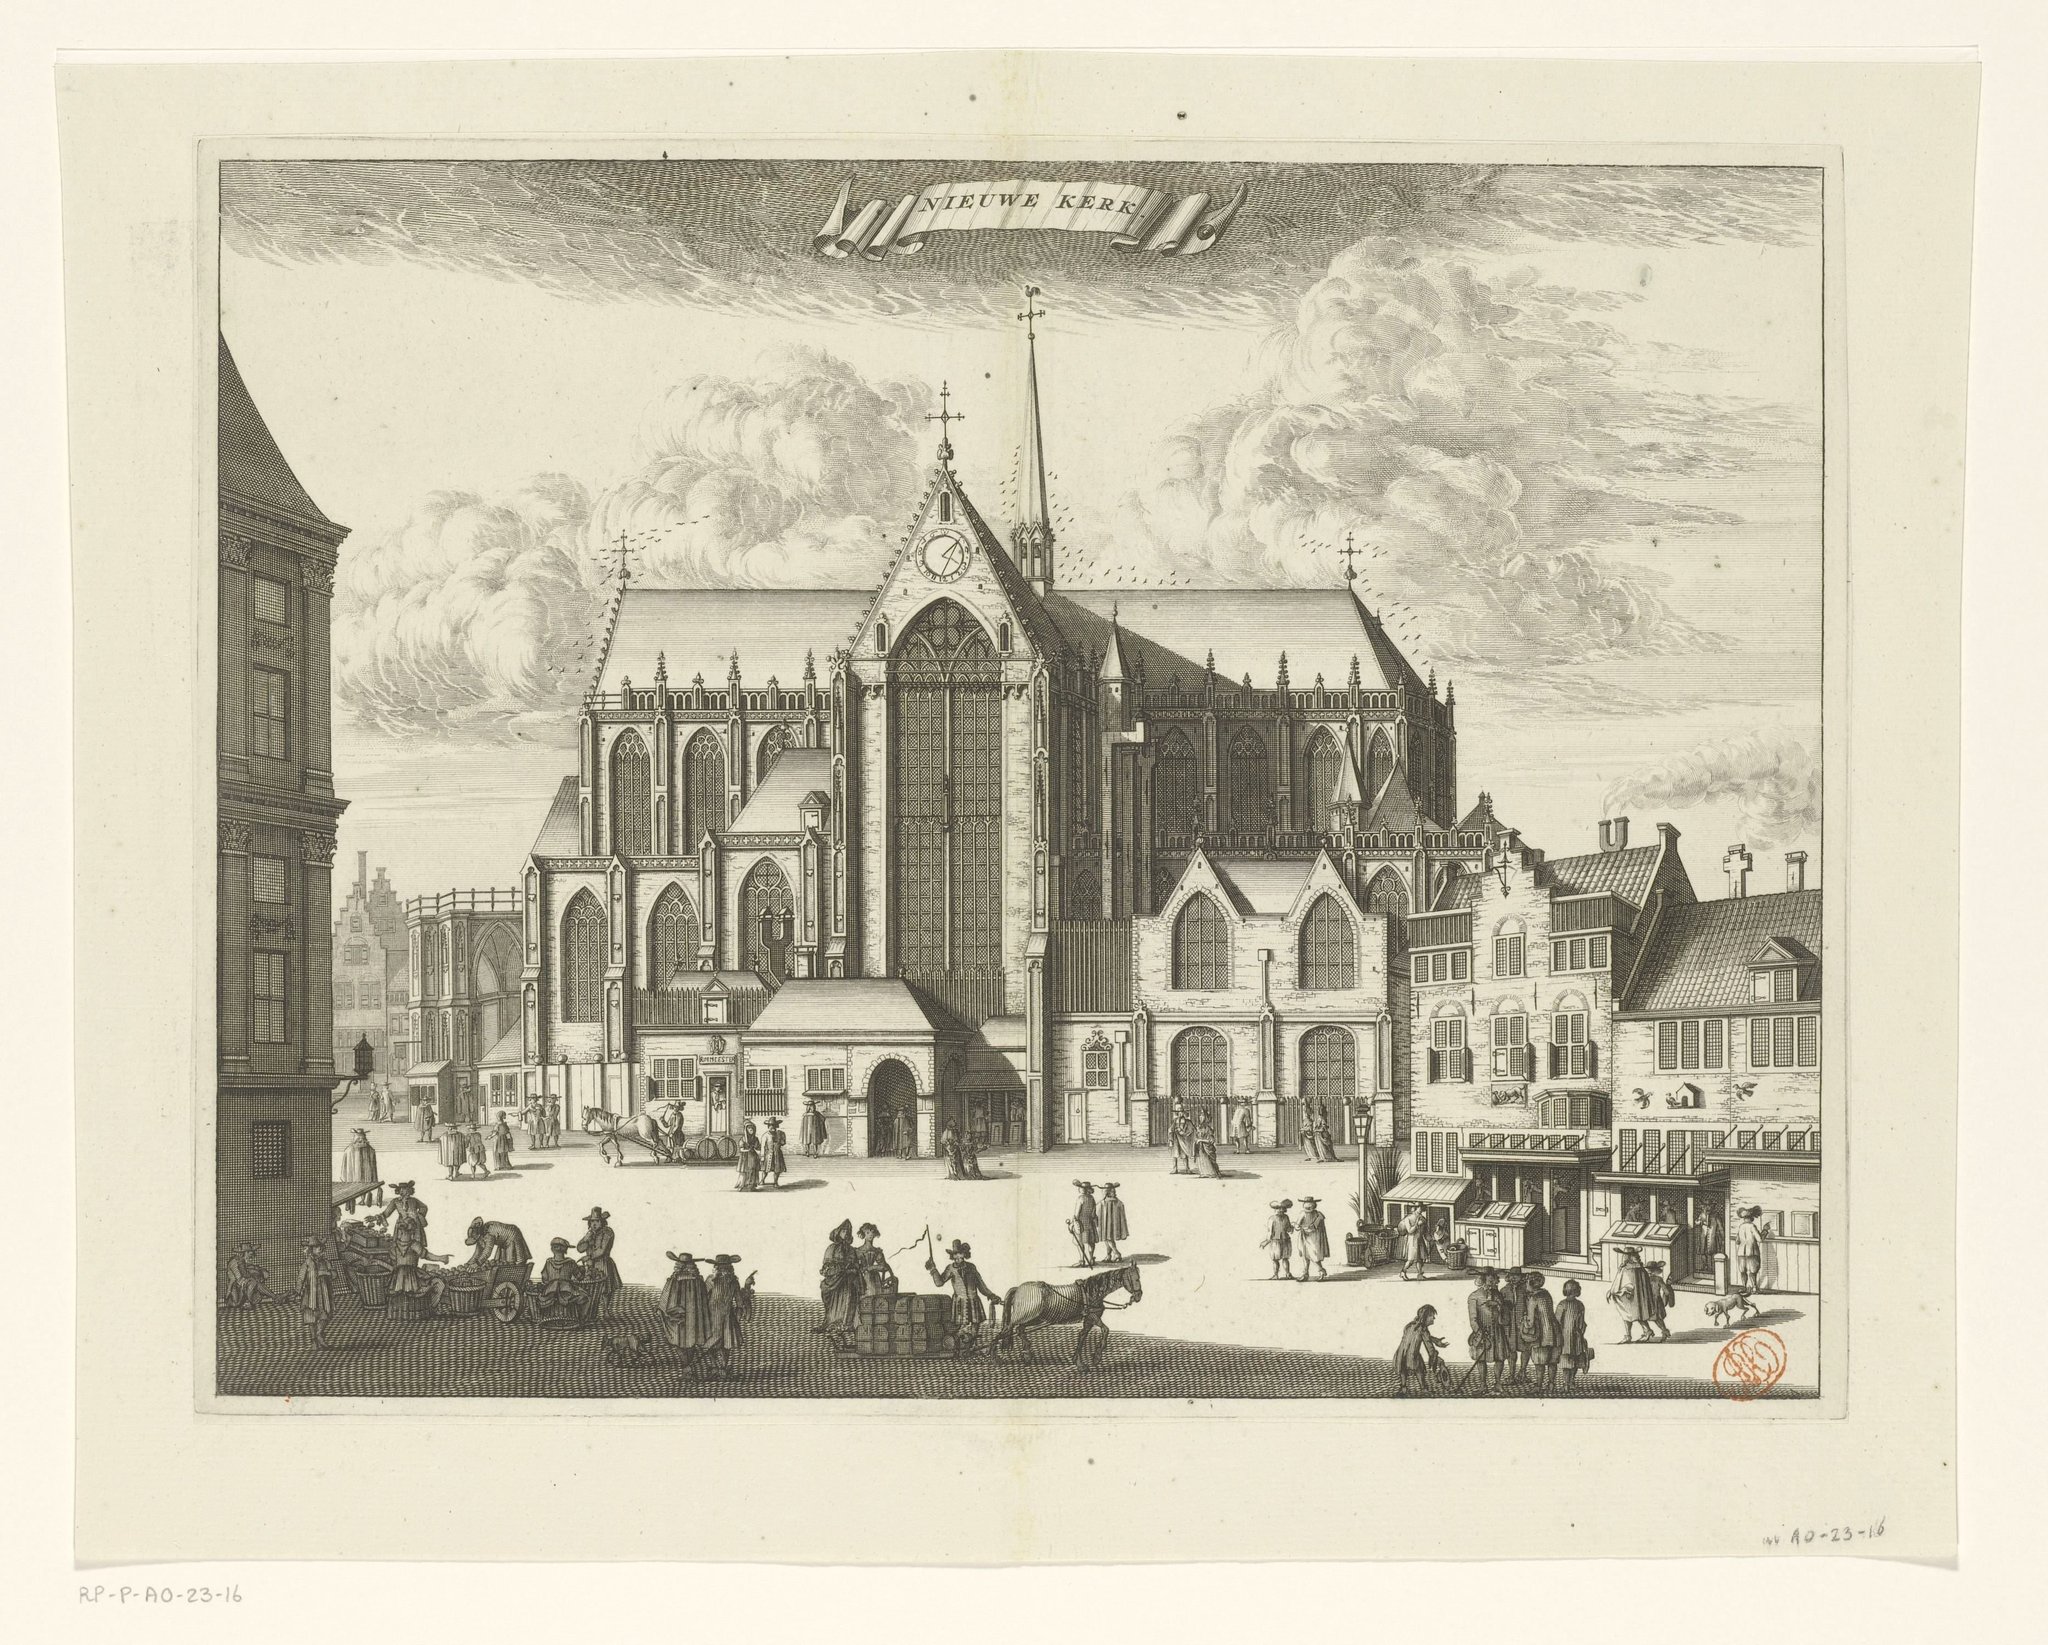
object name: print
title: Gezicht op de Nieuwe Kerk te Amsterdam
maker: Anonymous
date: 1693-1694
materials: paper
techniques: engraving, etching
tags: church (exterior), square, place, circus, etc. (+ city(-scape) with figures, staffage)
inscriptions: collector's mark: Lugt 195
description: Huidige staat van prent ook gebruikt in: Commelin, Caspar. Beschryvinge van Amsterdam, desselfs eerste oorspronk uyt den Huyse (…). 2 delen. Amsterdam: Abraham Wolfgang, Gillis Janssonius van Waesberge, Johannes Janssonius van Waesberge II, weduwe Dirk Boom I, Hendrick Boom en Rembertus Goethals, 1693. En in: Commelin, Caspar. Beschryvinge van Amsterdam, zynde een naukeurige verhandelinge van desselfs eerste oorspronk uyt (…). 2 delen. Amsterdam: weduwe Aart Dircksz Oossaan, 1694. Latere staat ook gebruikt in: Commelin, Caspar. Beschryvinge van Amsterdam, zynde een naukeurige verhandelinge van desselfs eerste oorspronk uyt (…). 2 delen. 2e druk. Amsterdam: Andries van Damme, Johannes Ratelband, weduwe A. van Aaltwyk en Hermanus Uytwerf, 1726.